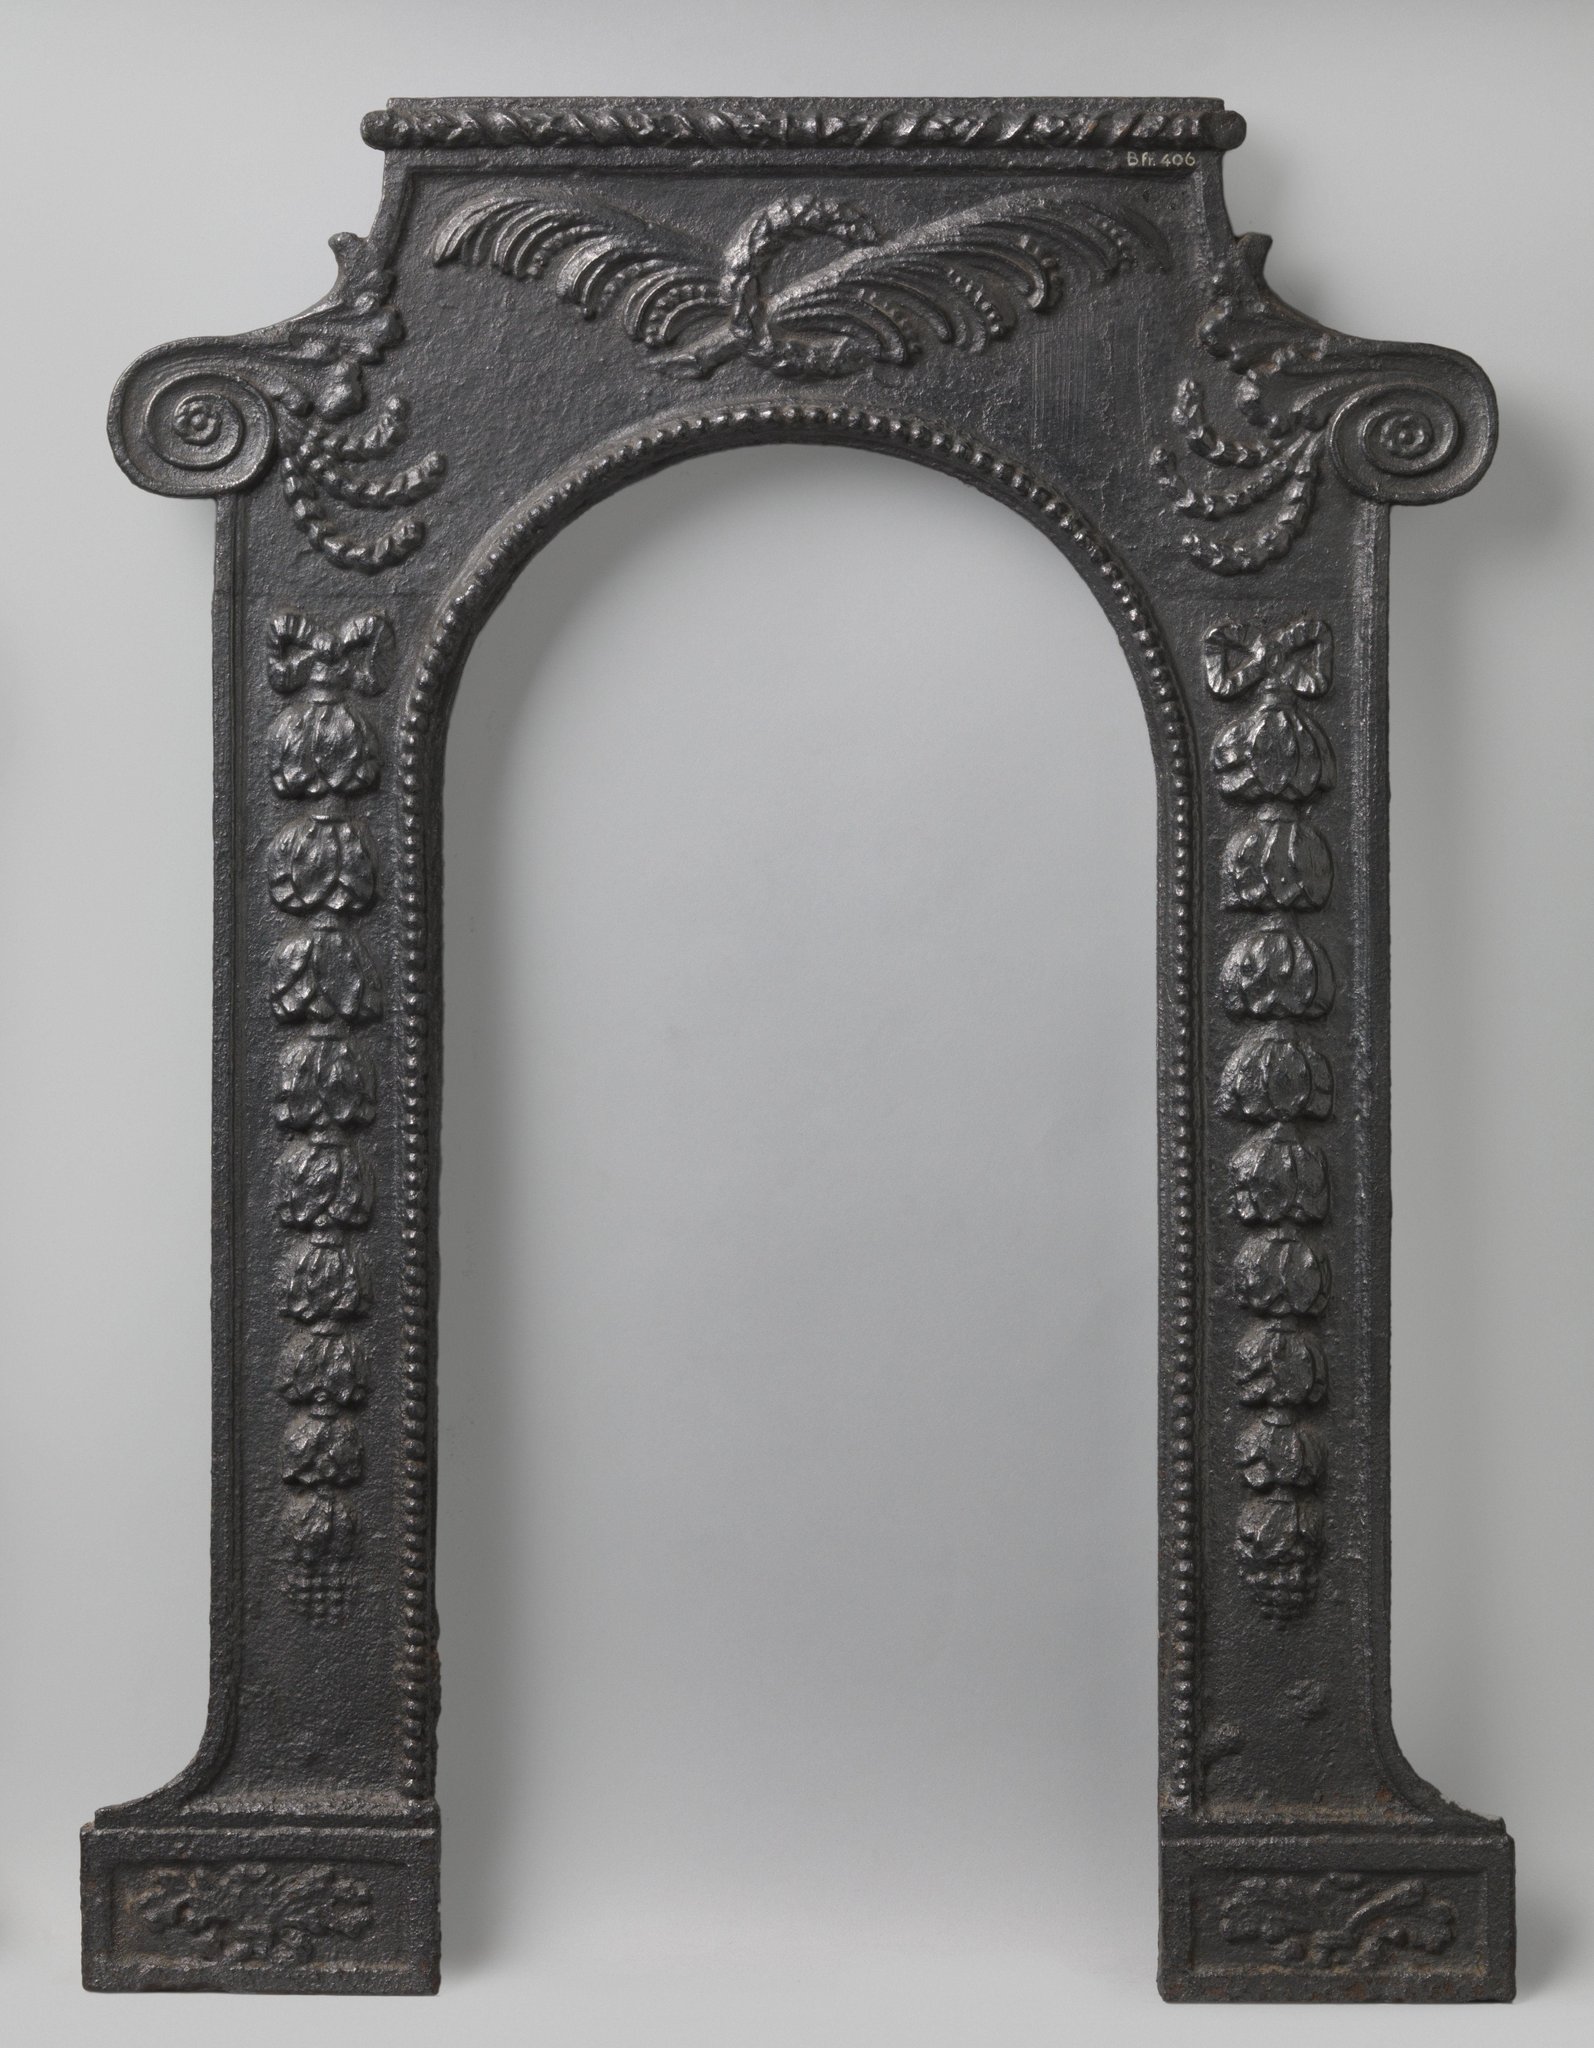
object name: haardombouw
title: Gietijzeren plaat voor ombouw van de haard, met palmtakken en een krans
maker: Anonymous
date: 1675-1725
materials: iron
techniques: casting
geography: germany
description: Plaat van gietijzer, onderdeel van de haardombouw. De opening wordt omrandt met een eierlijst. De pilasters zijn versierd met bloemfestoenen en bovenaan voluten. Het geheel wordt bekroond met twee palmtakken door een krans gestoken.